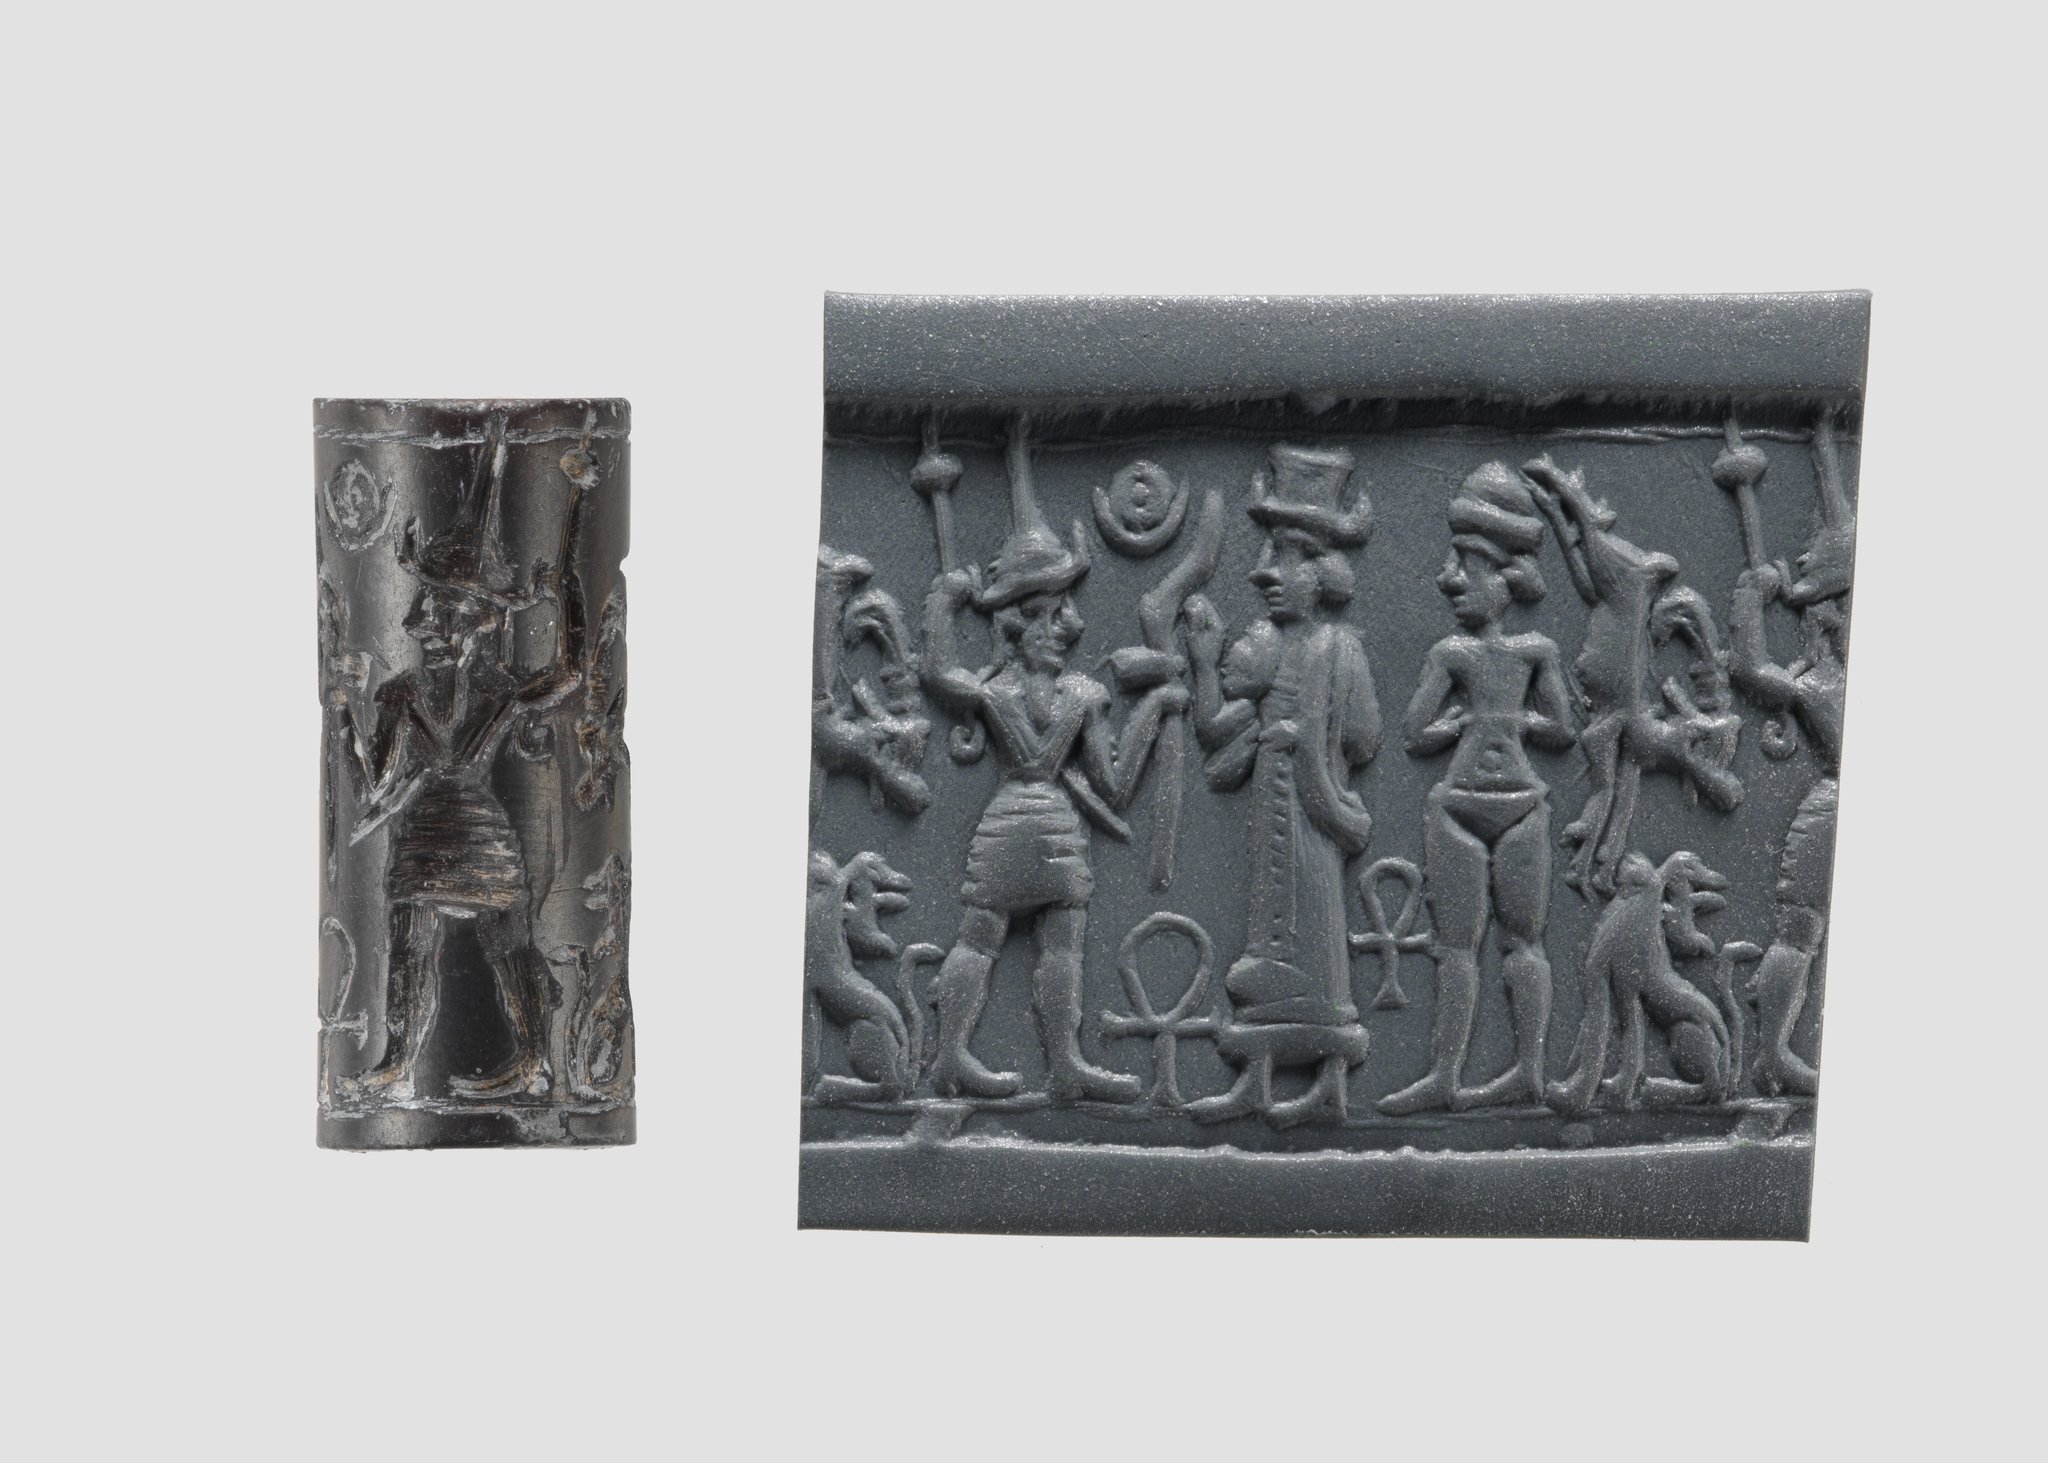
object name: cylinder seal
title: Cylinder seal and modern impression: smiting weather god before a Syrian goddess, nude goddess; ankh symbols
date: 1720-1650 BCE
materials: mineral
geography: syria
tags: gods,goddess